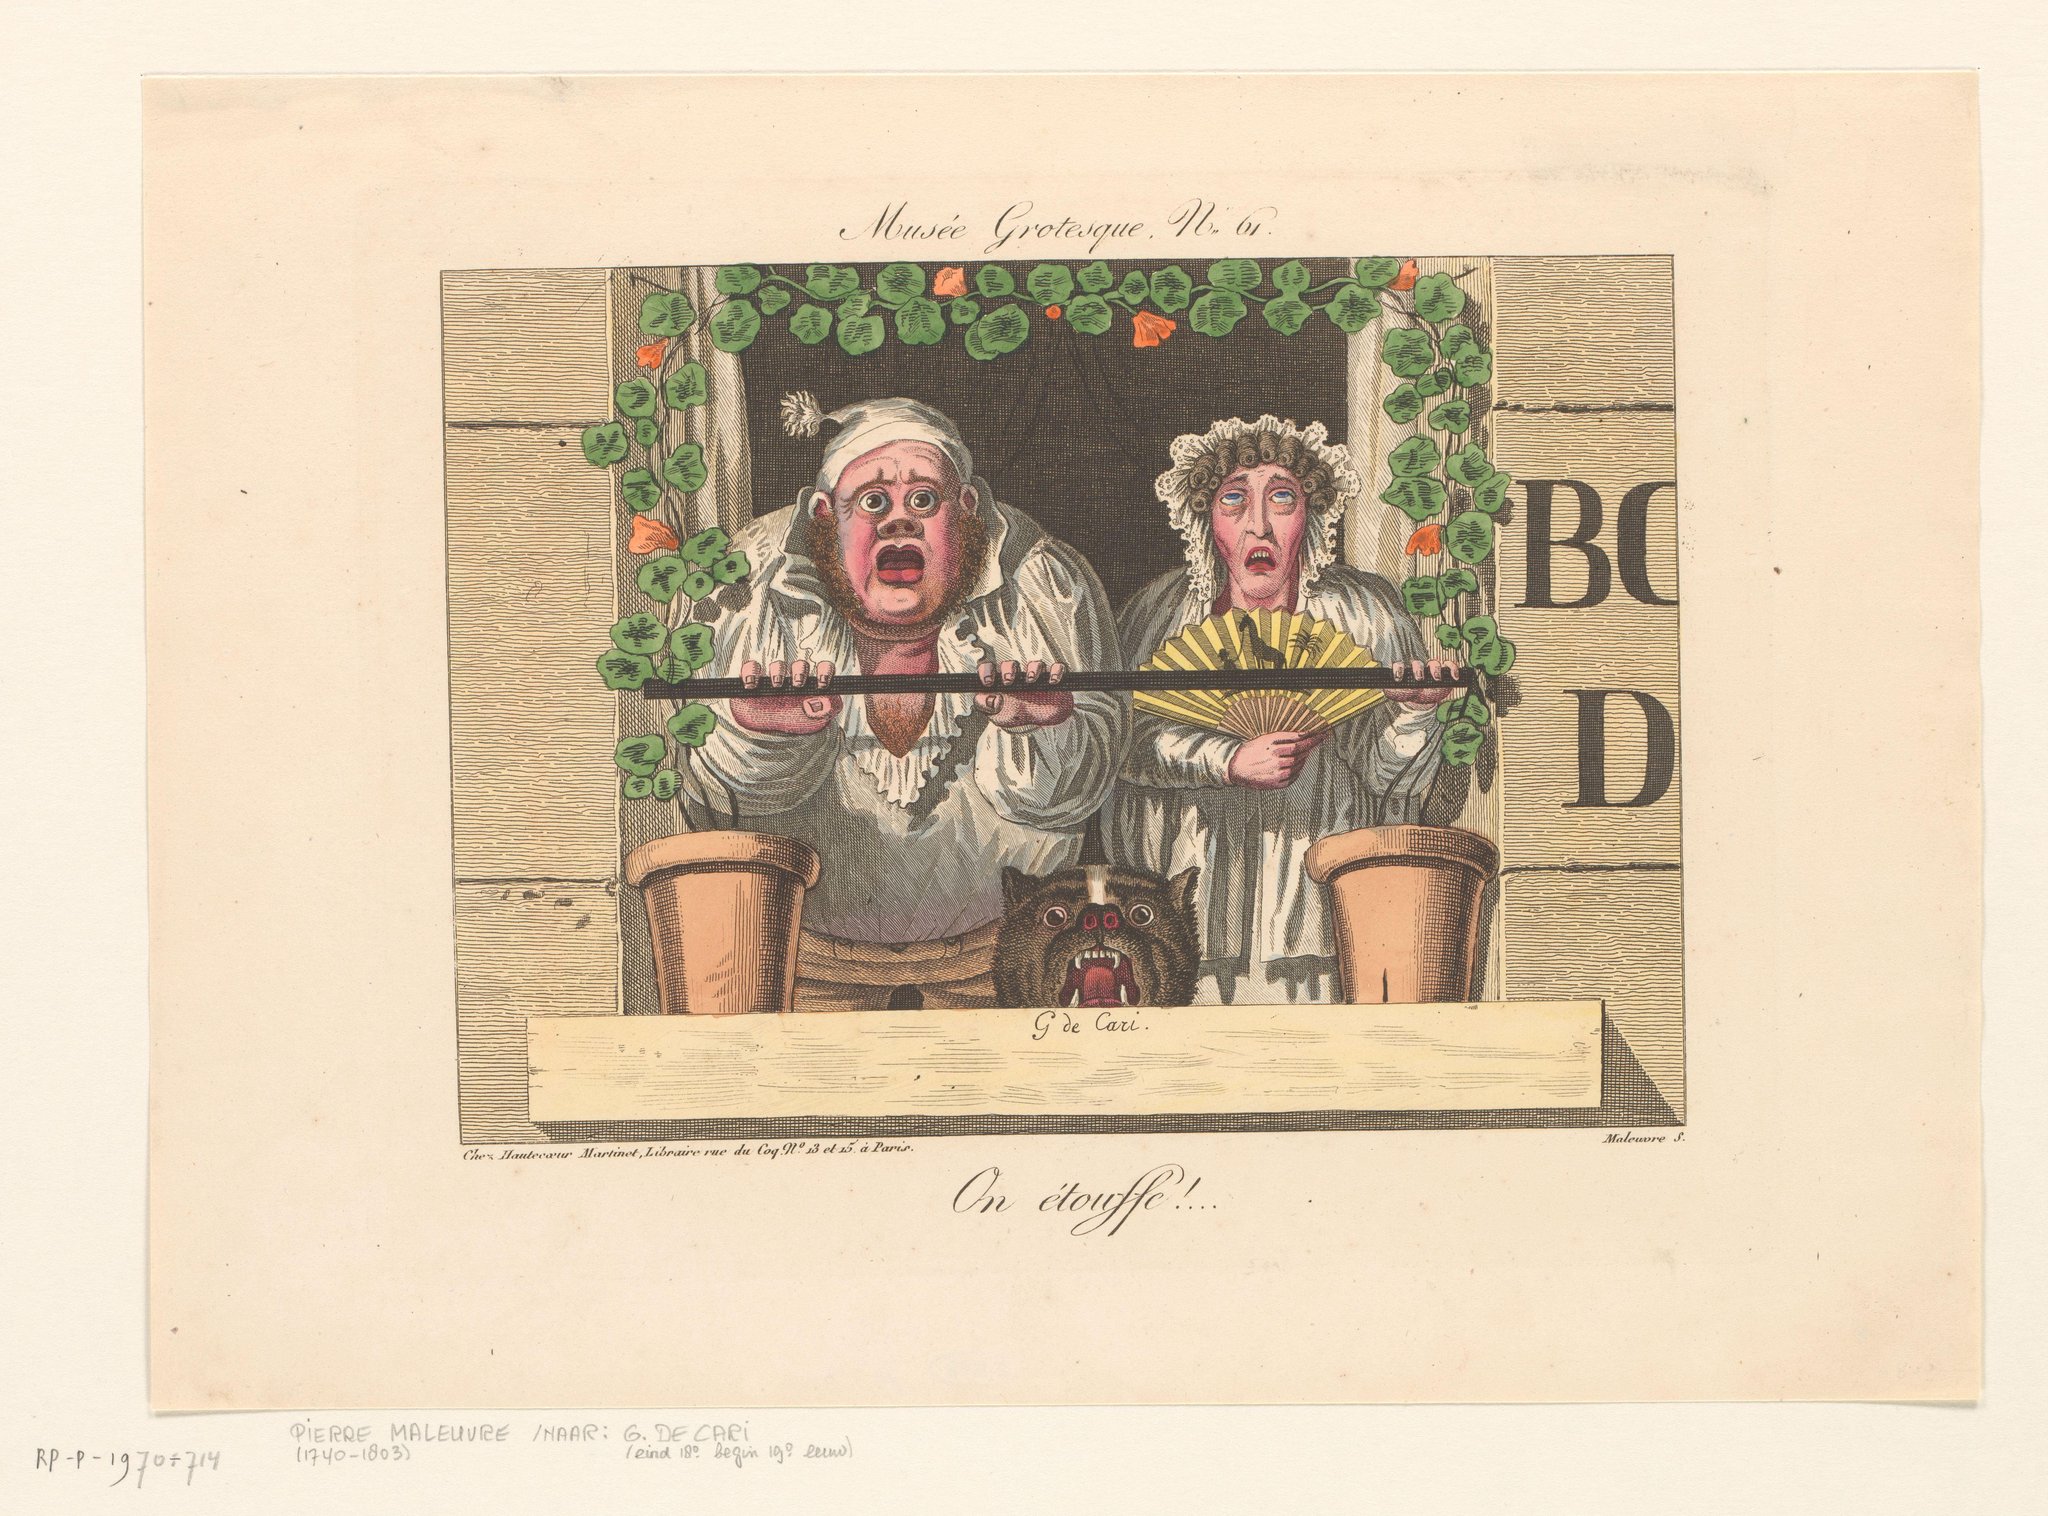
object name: cartoon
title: We stikken!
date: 1820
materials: paper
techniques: etching, hand coloring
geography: paris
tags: heat-wave, waking up, dog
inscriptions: collector's mark: Lugt 2228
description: Een man en een vrouw in nachtkleding, slaapmuts op het hoofd, staan voor een open venster. De vrouw heeft een waaier in de hand. Onderin ook een hond. Vanwege het warme weer.